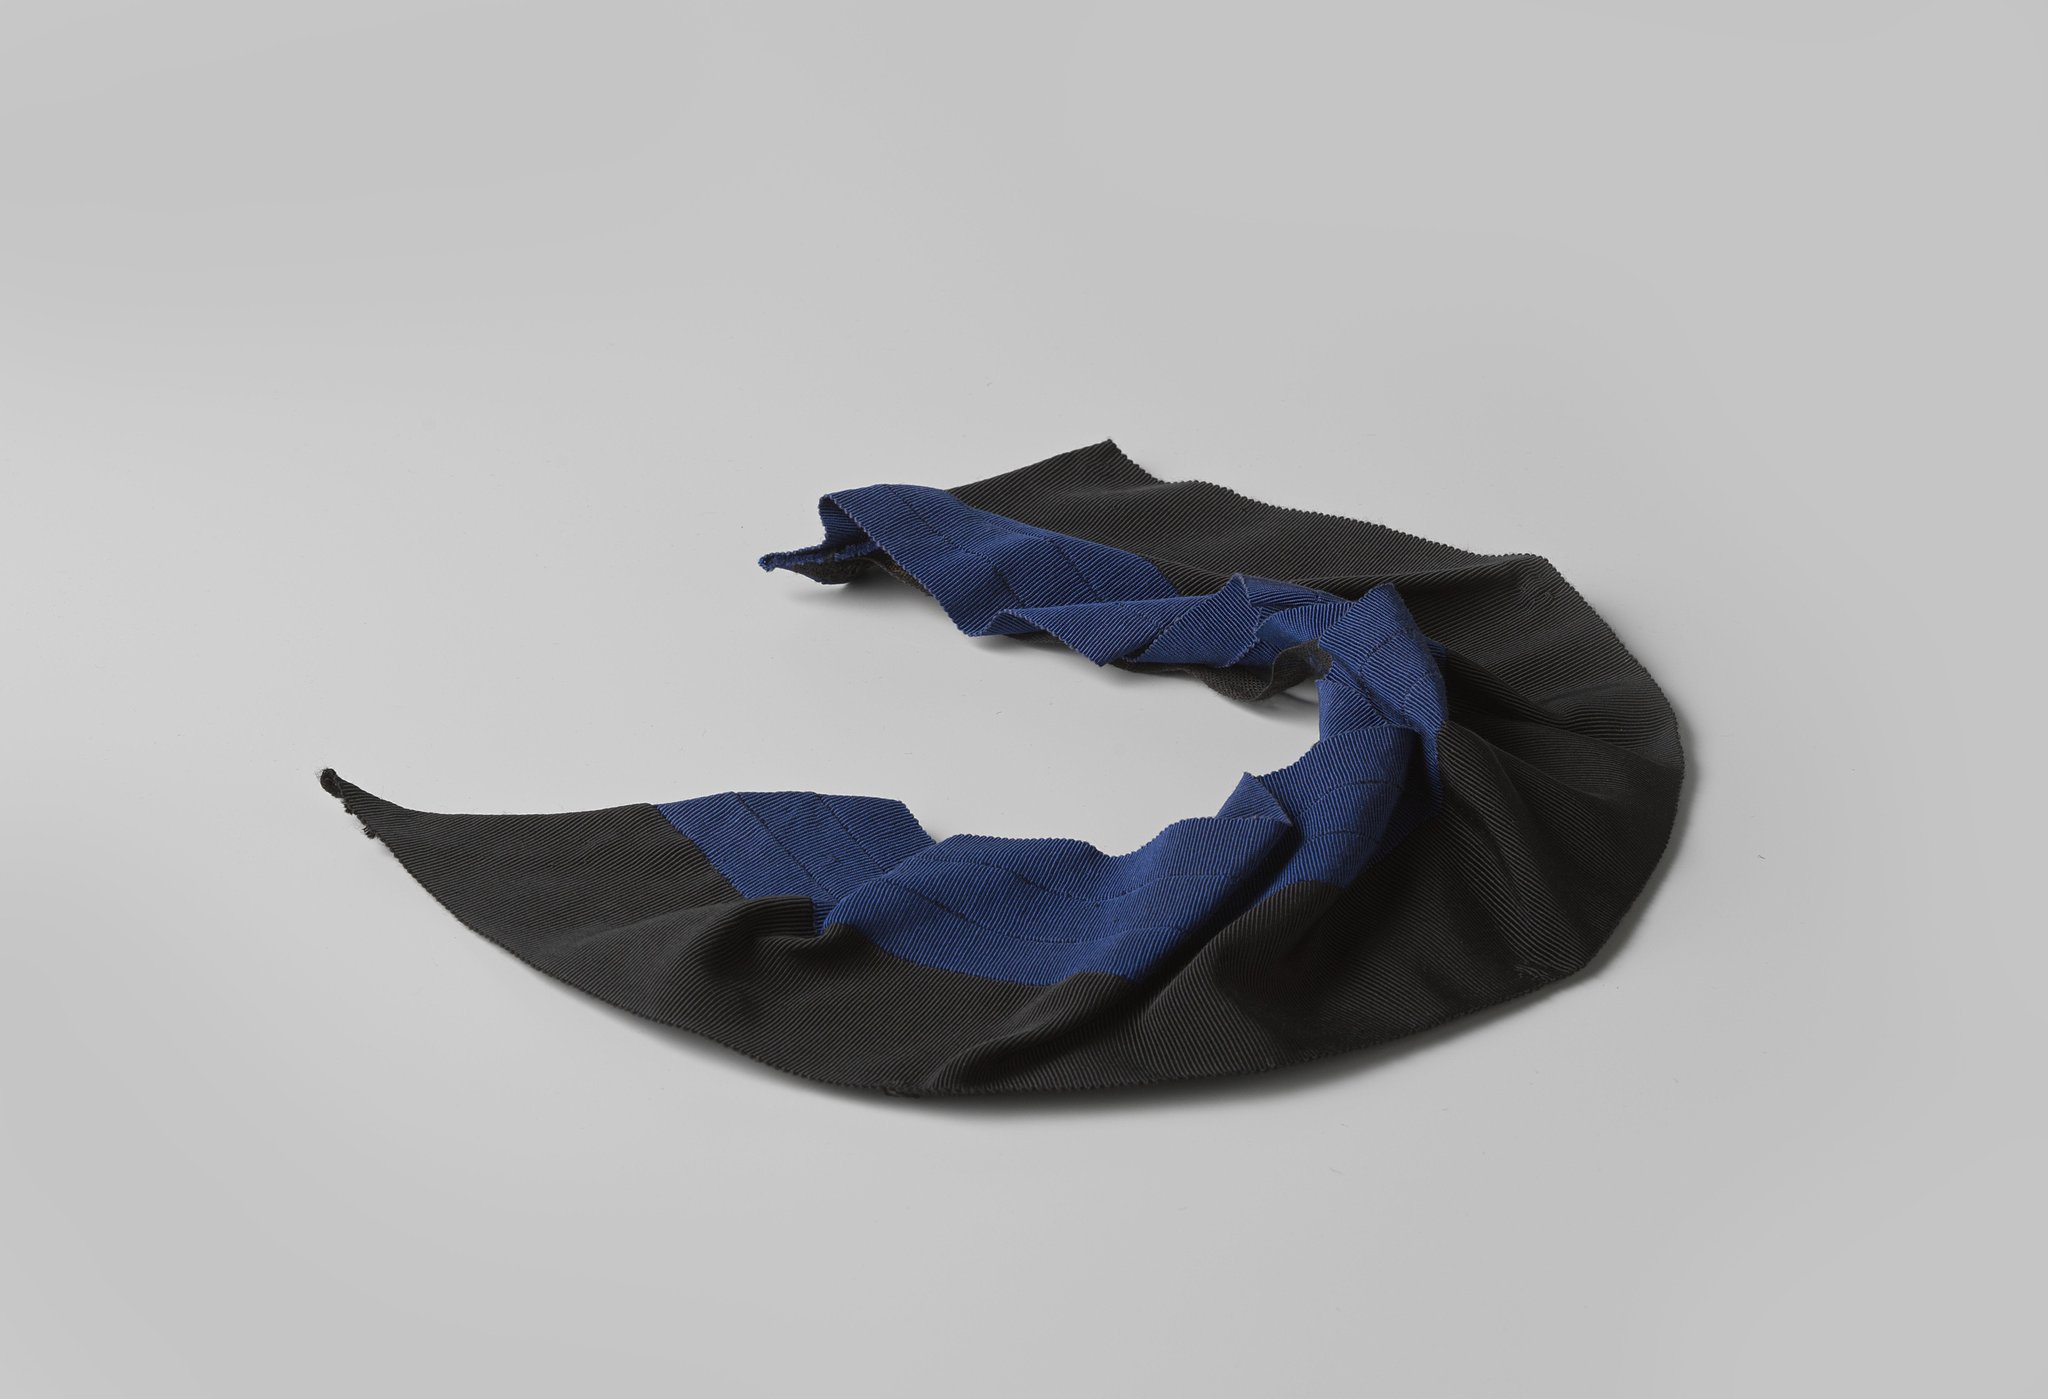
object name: belt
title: Losse ceintuur van blauwe crêpe, met zwarte knoop te sluiten met een zwarte tres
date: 1935-1940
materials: textile, silk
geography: amsterdam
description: Kleine vilten hoed met platte vierkante bol en brede opstaande rand. Rond de bol een effen zwarte of een blauw-zwarte brede ripsband, naar keuze. Oorspronkelijk was deze hoed b. genummerd, maar de losse ceintuur draagt al nr. b; bij het vinden van deze hoed in het depot, de nummering aanpassen !